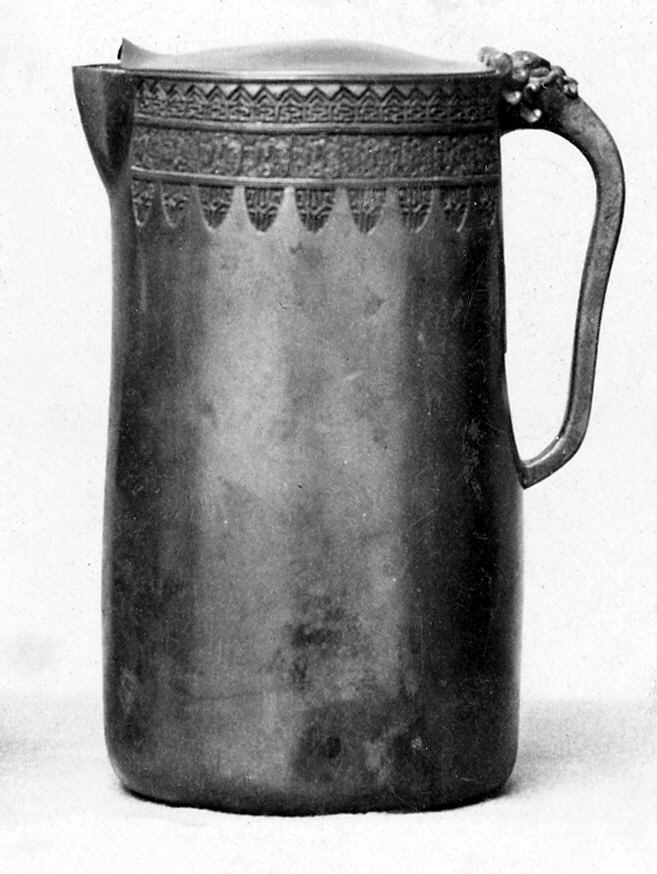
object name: pot with cover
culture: japanese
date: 1801-1900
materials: bronze